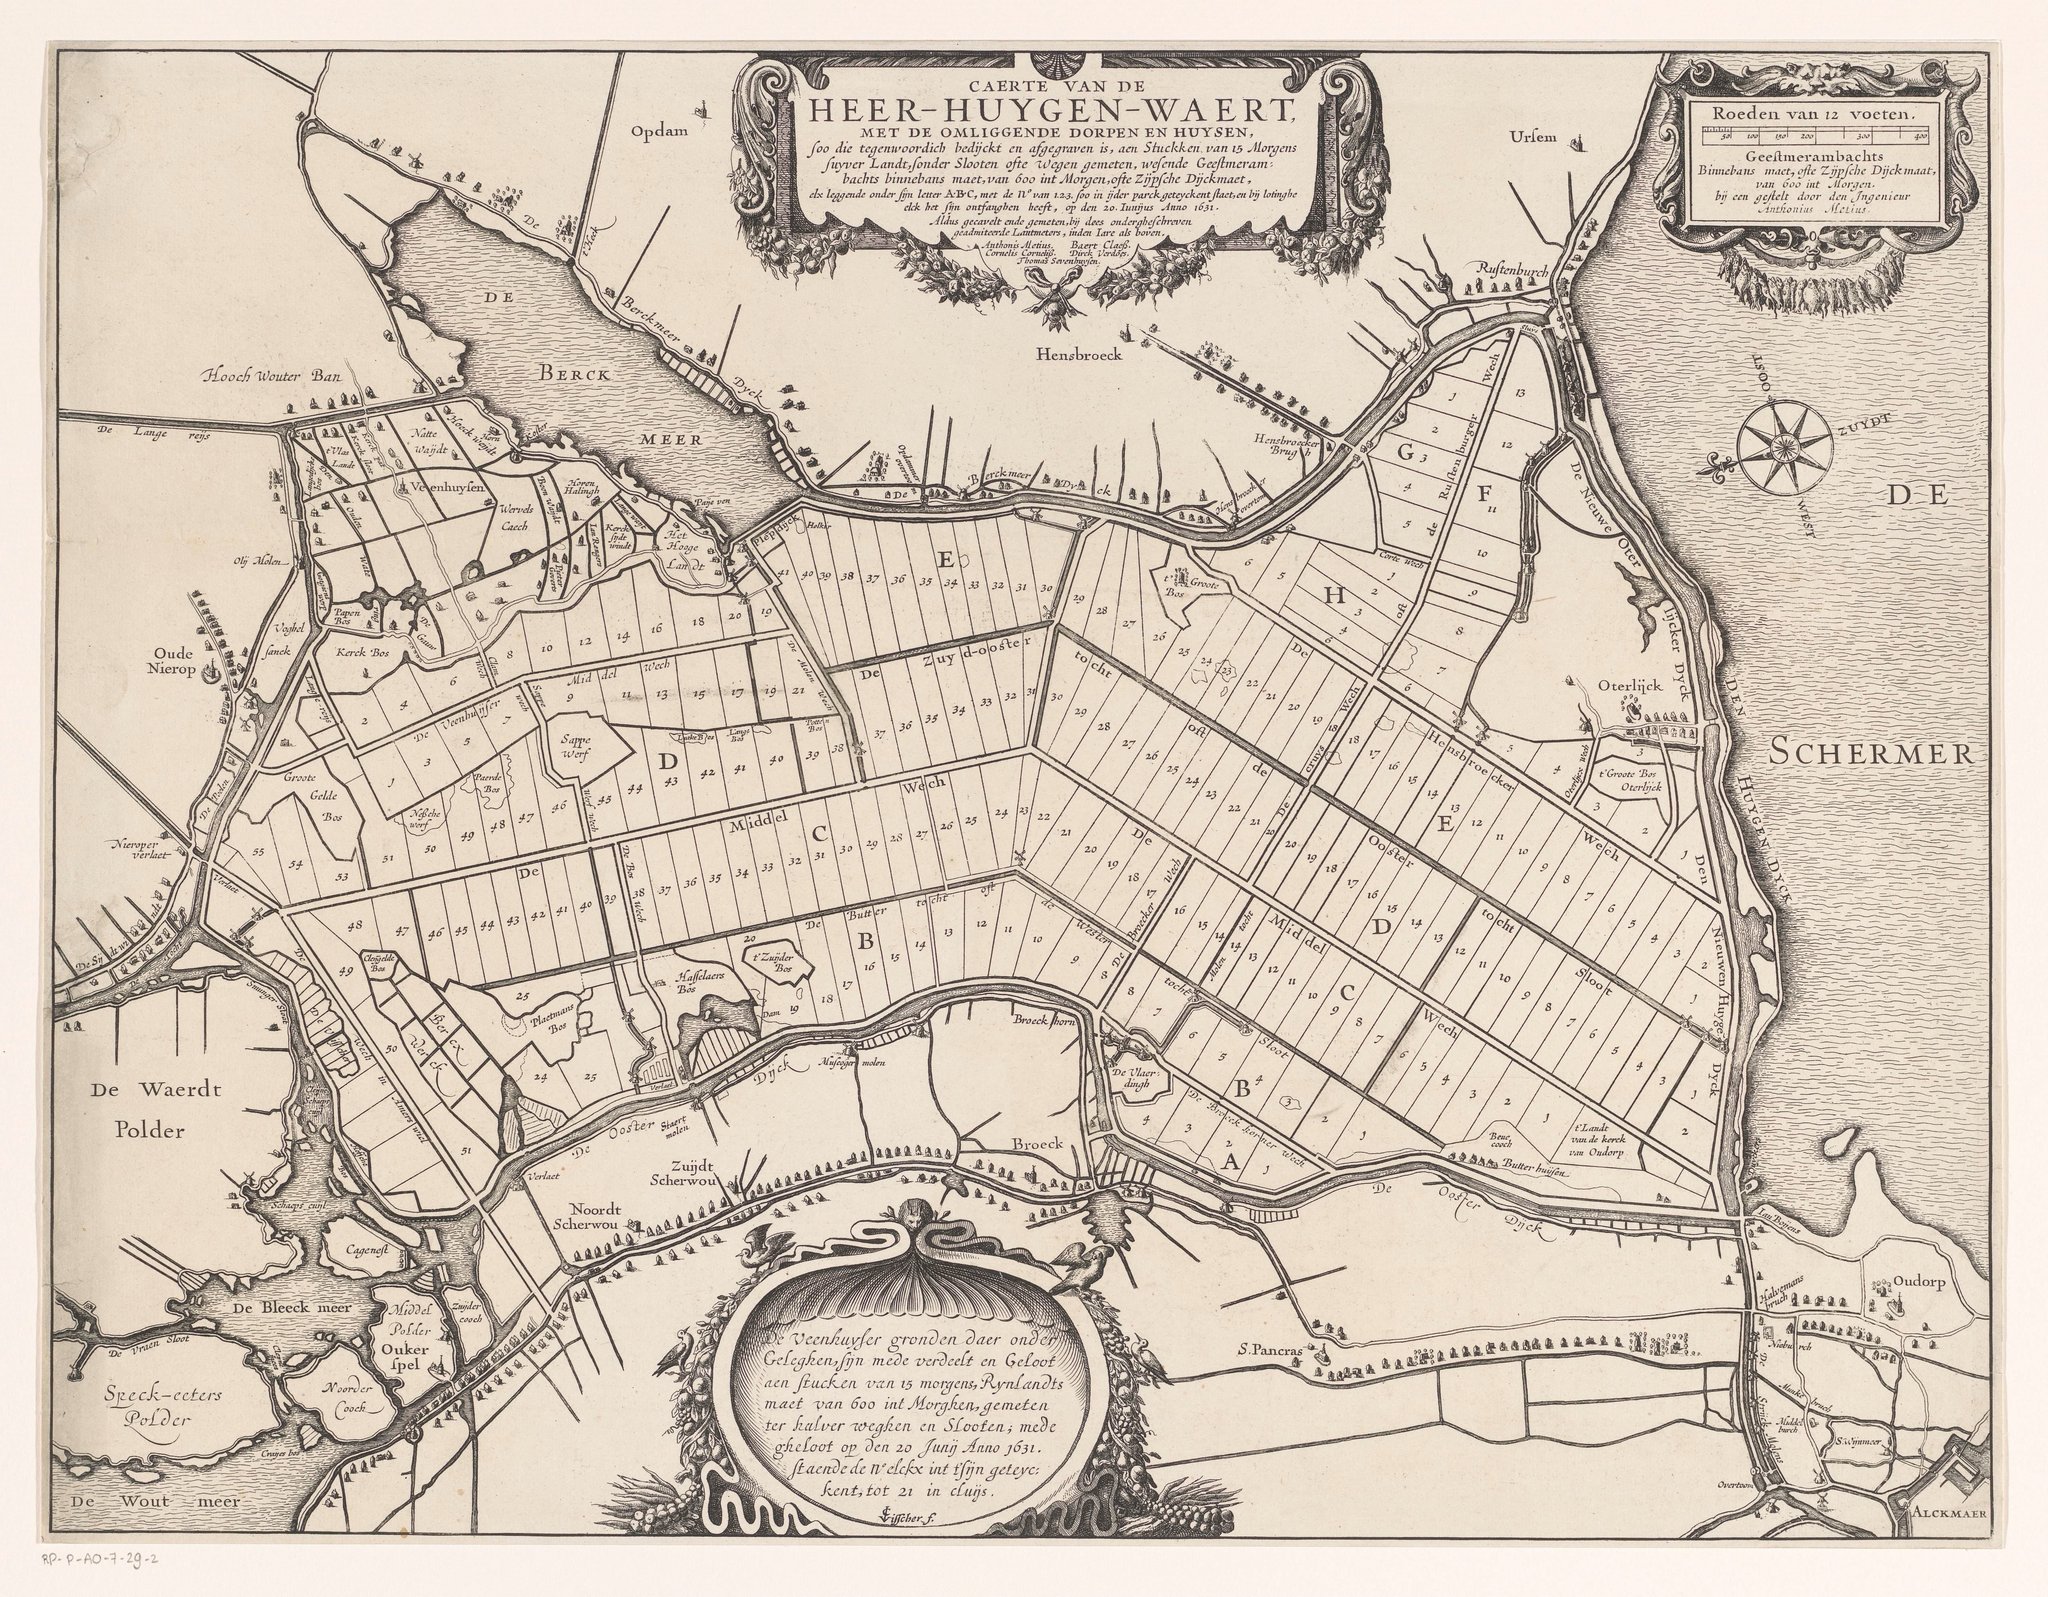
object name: print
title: Kaart van de verlote kavels in de Heerhugowaard, 1631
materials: paper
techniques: engraving, etching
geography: northern netherlands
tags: maps of separate countries or regions, polder, reclaimed land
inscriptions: collector's mark: Lugt 19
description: Kaart van de verlote genummerde kavels in de Heerhugowaard, 20 juni 1631. Bovenaan in het midden de titelcartouche. Rechtsboven een schaalstok: Roeden van 12 voeten, Geesterambachts binnebans maet, ofte Zijpsche dijckmaat, van 600 int morgen, bij een gestelt door den ingenieur Anthonius Metius. Onderaan een cartouche met tekst over de Veenhuyser gronden.